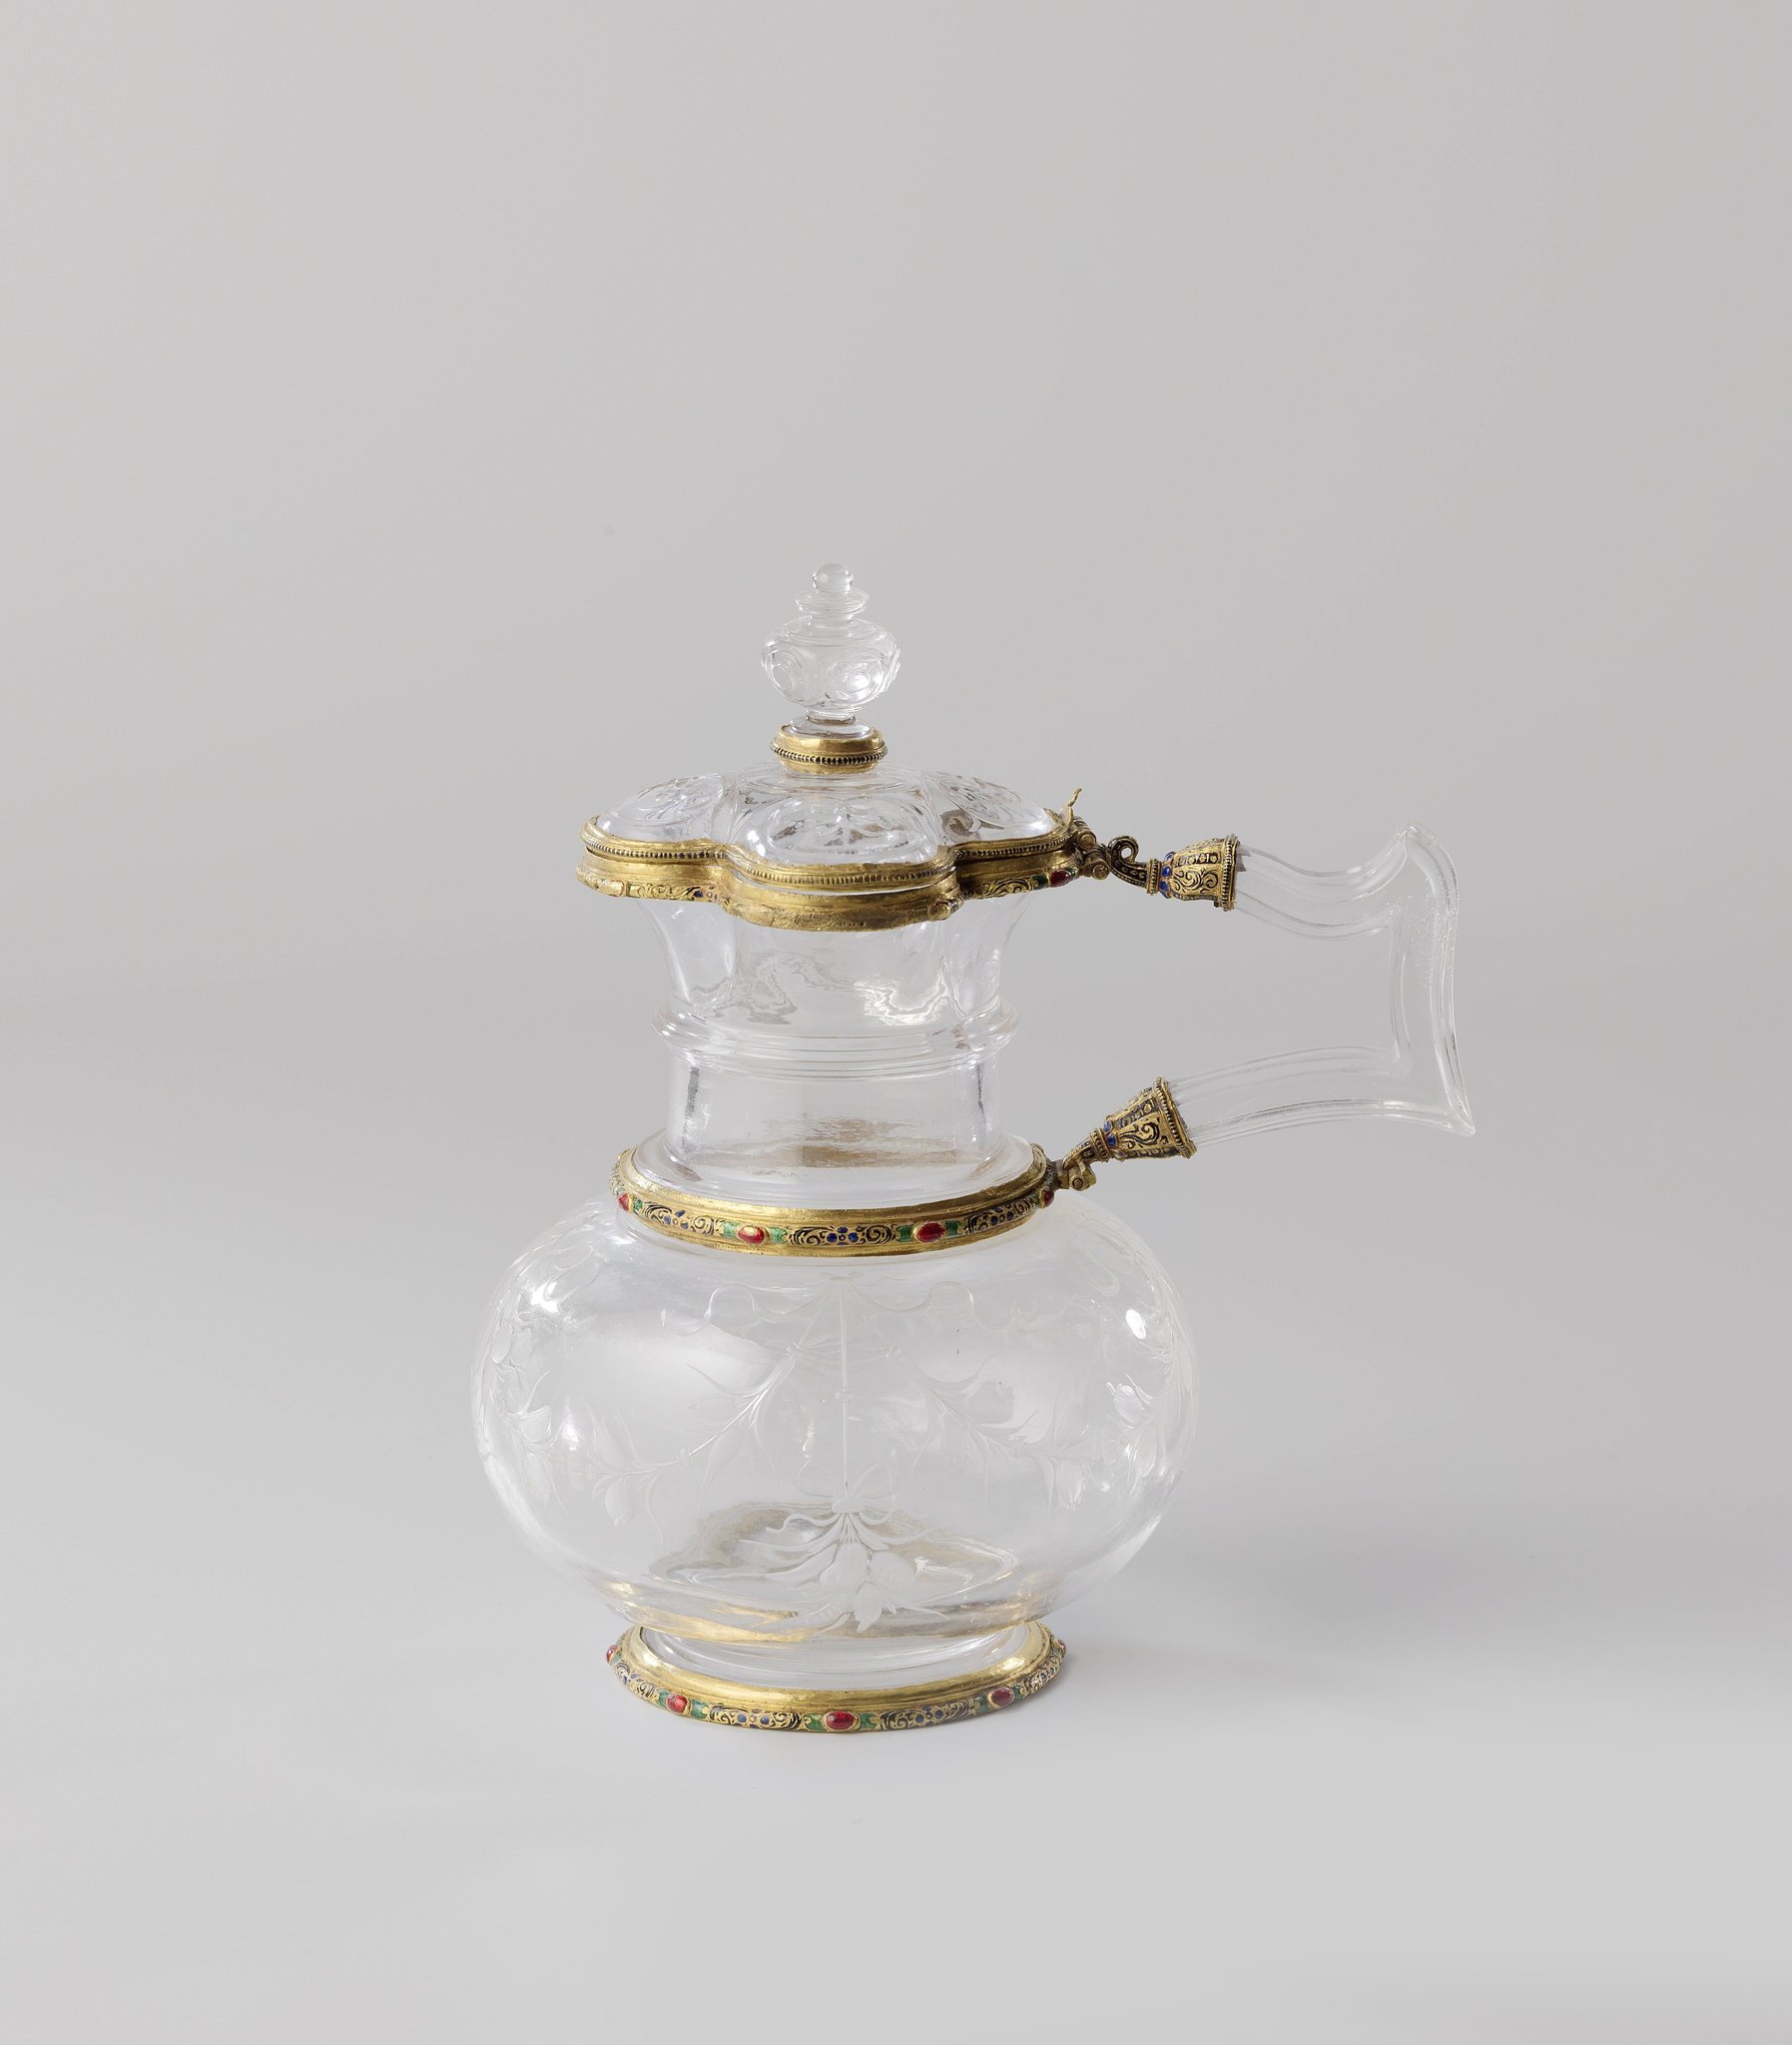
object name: ewer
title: Lidded jug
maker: Anonymous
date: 1550-1570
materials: gold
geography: northern italy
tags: ornament derived from plant forms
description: Bunches of fruit and floral garlands ornament the body and lid of this jug. The foliate scrolls recur in black enamel on the mount.